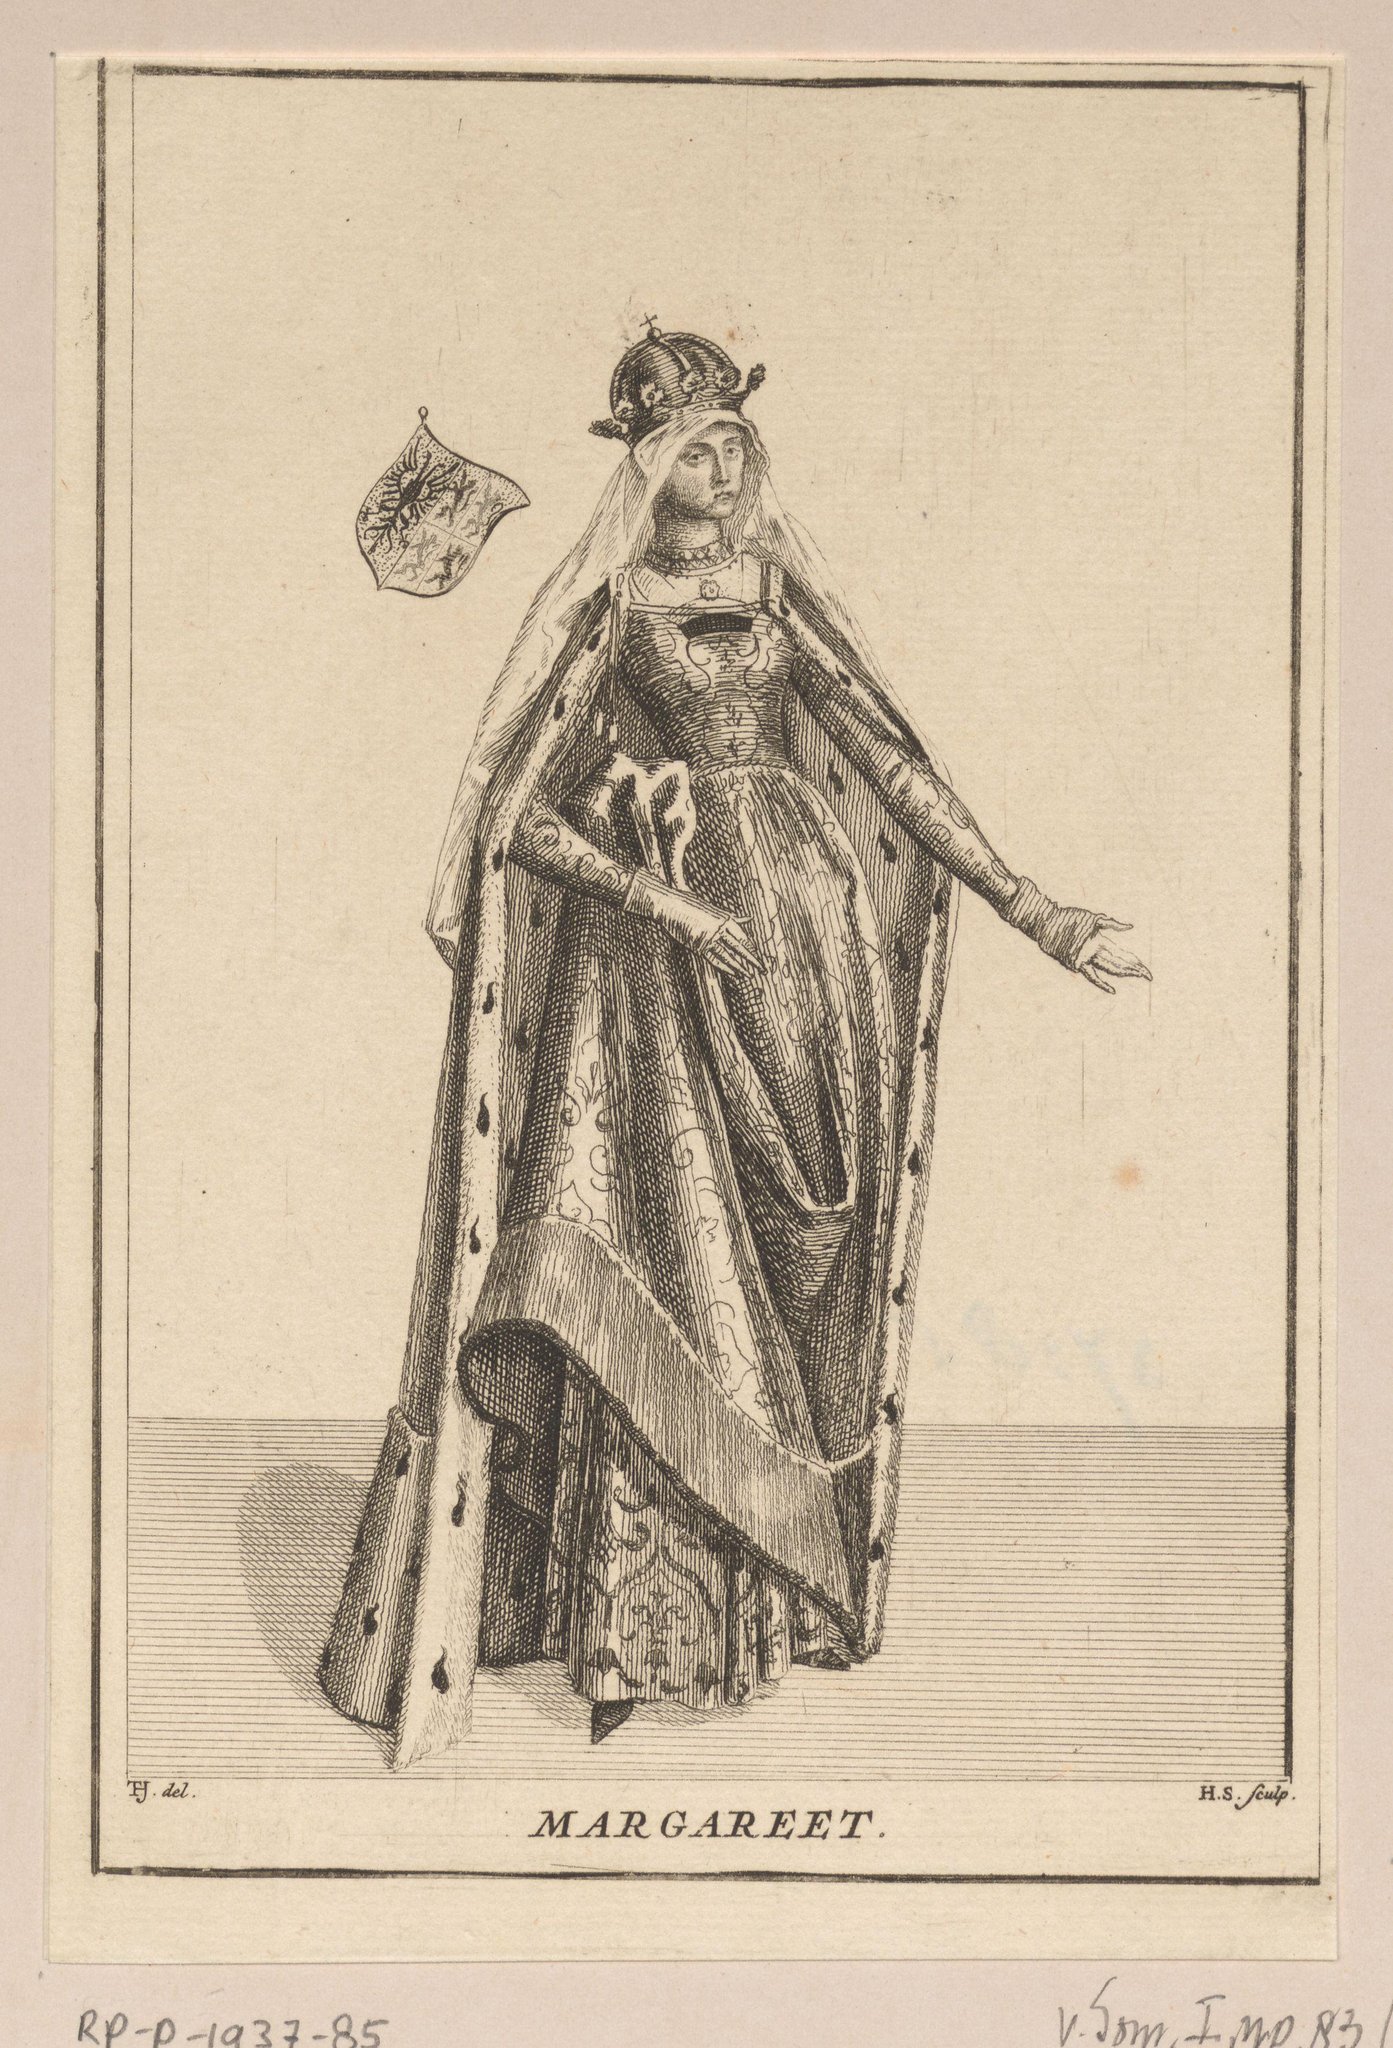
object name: print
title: Portret van Margaretha II van Henegouwen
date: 1745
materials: paper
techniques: etching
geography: haarlem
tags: historical persons - bb - woman, crown (symbol of sovereignty) - bb - female ruler, armorial bearing, heraldry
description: Prent waarschijnlijk uit: Langendijk, Pieter. De Graaven van Holland, in jaardichten beschreven door Pieter Langendijk. Verrijkt met alle de beeldtenissen dier prinsen, naauwkeurig getekend naar de echte aloude tafereelen of de zaal van't raadhuis der stad Haarlem. Haarlem: J. Bosch, 1745, dl. 2.